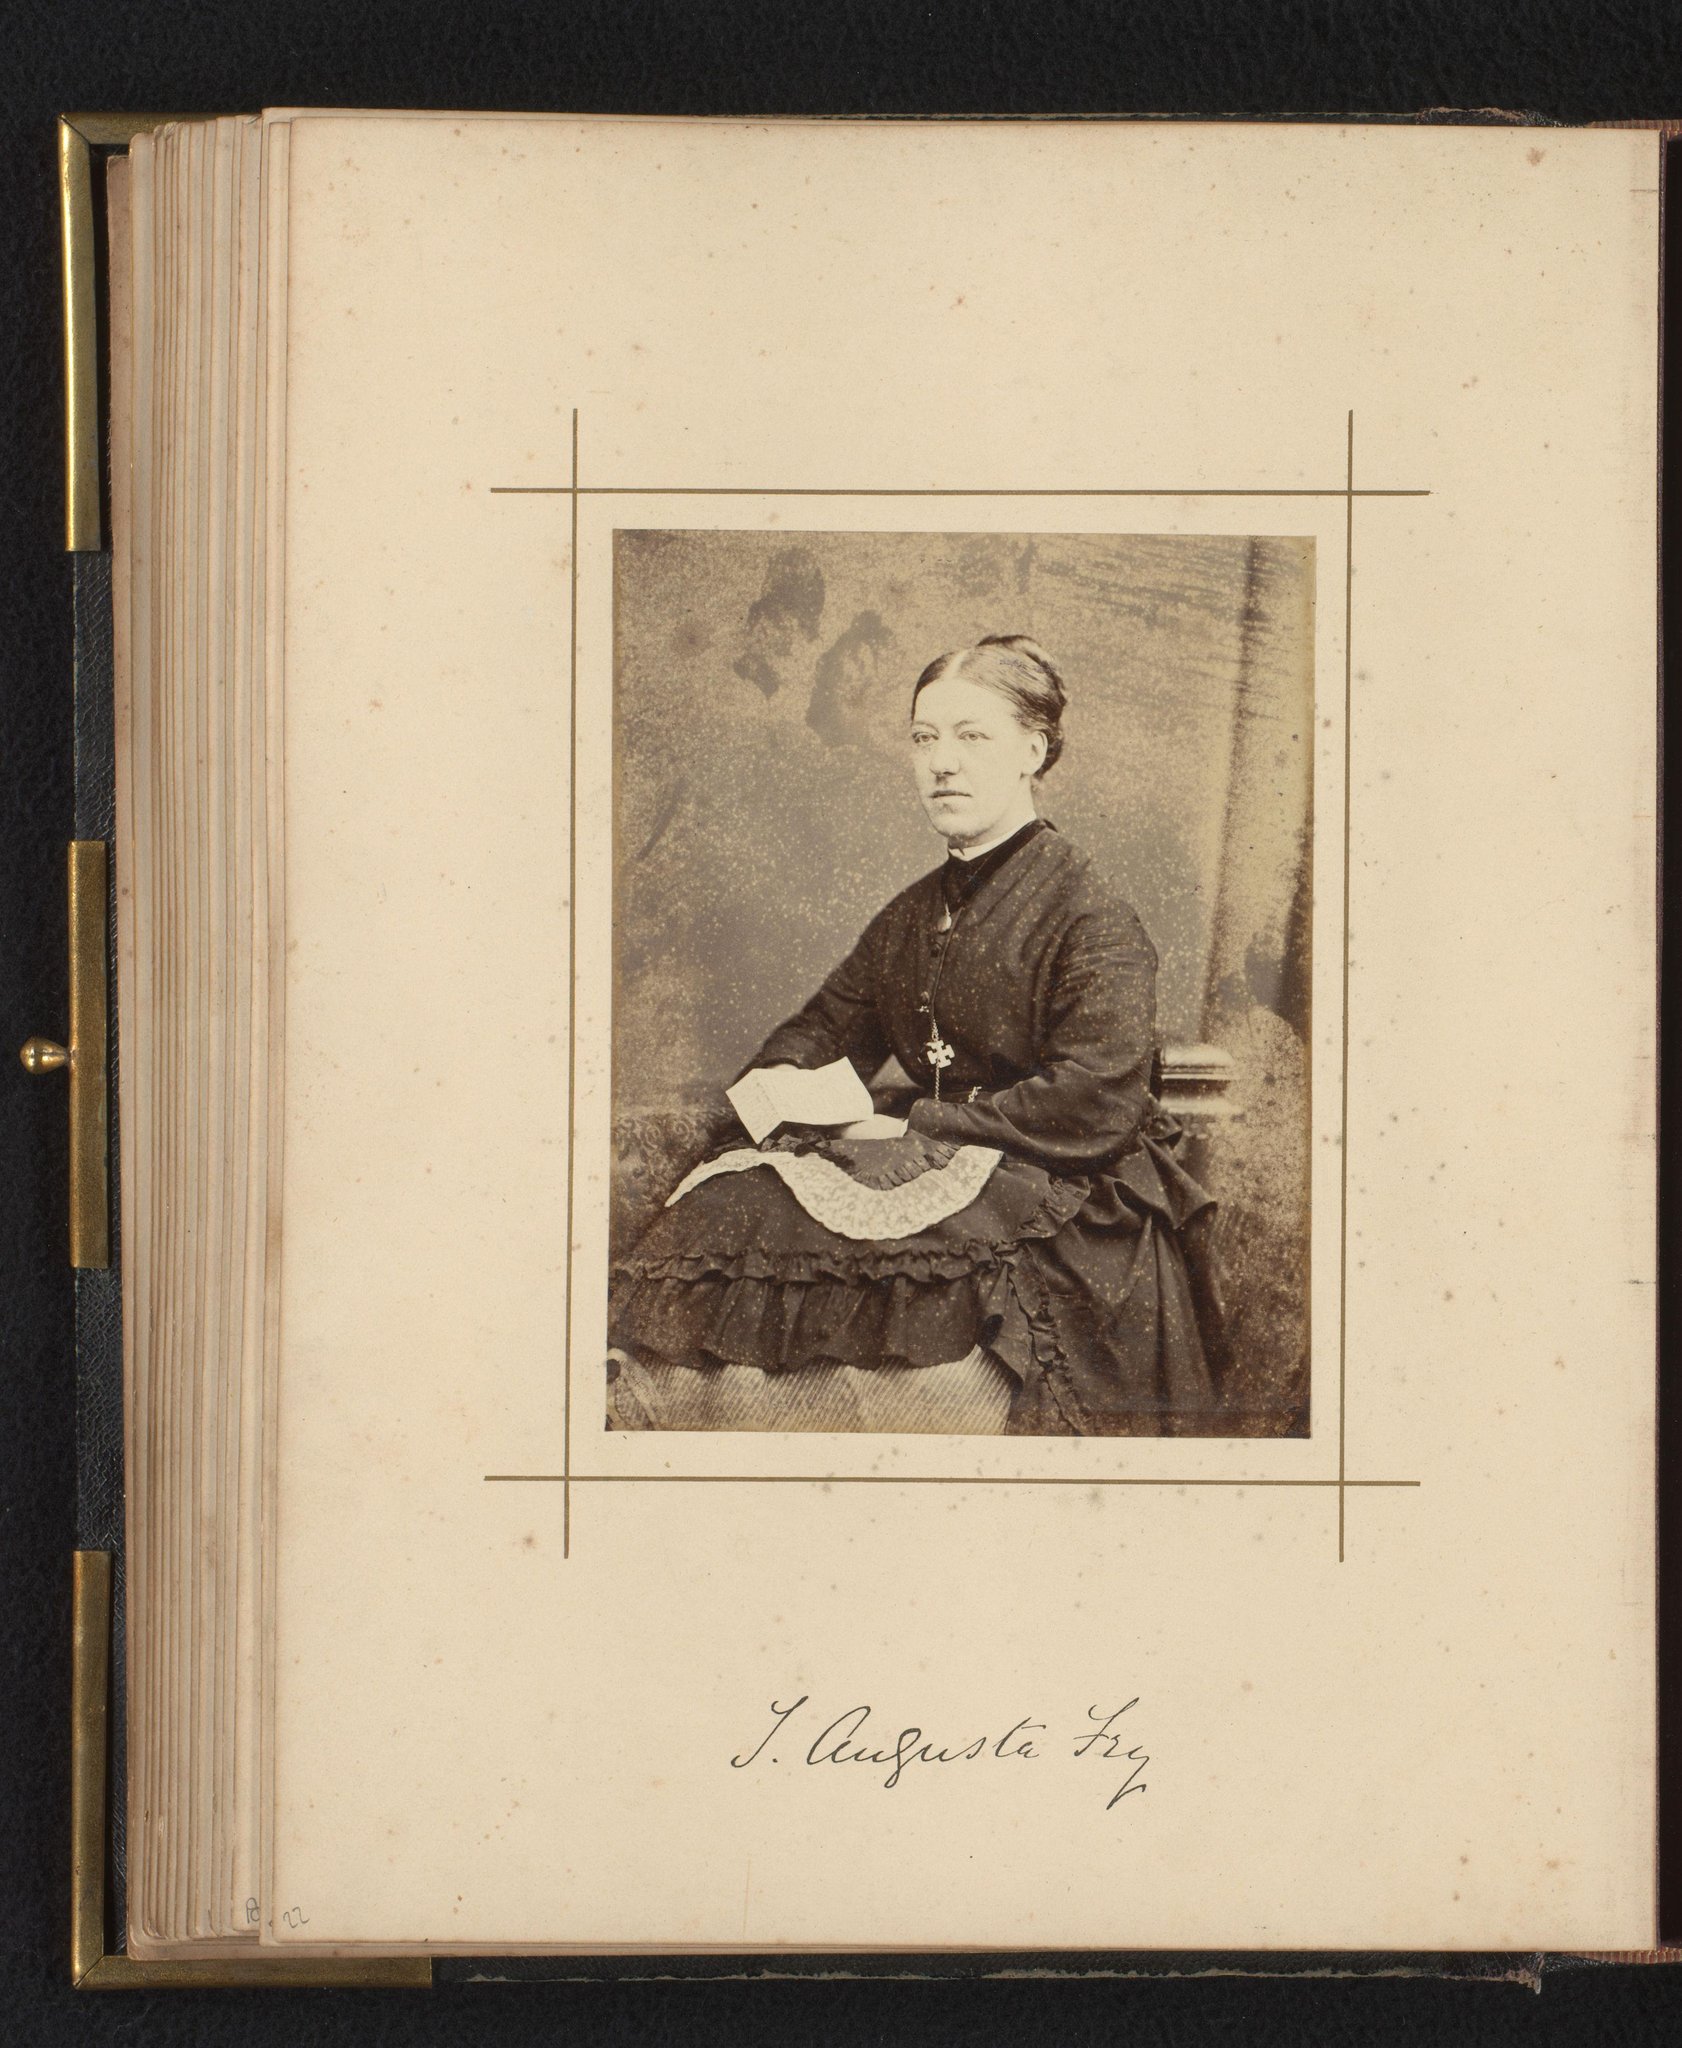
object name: photograph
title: Portret van J. Augusta Fry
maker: Anonymous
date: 1866-1871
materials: photographic support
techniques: albumen print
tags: sitting figure - aa - female human figure, historical persons - bb - woman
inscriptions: name: ‘J. Augusta Fry’